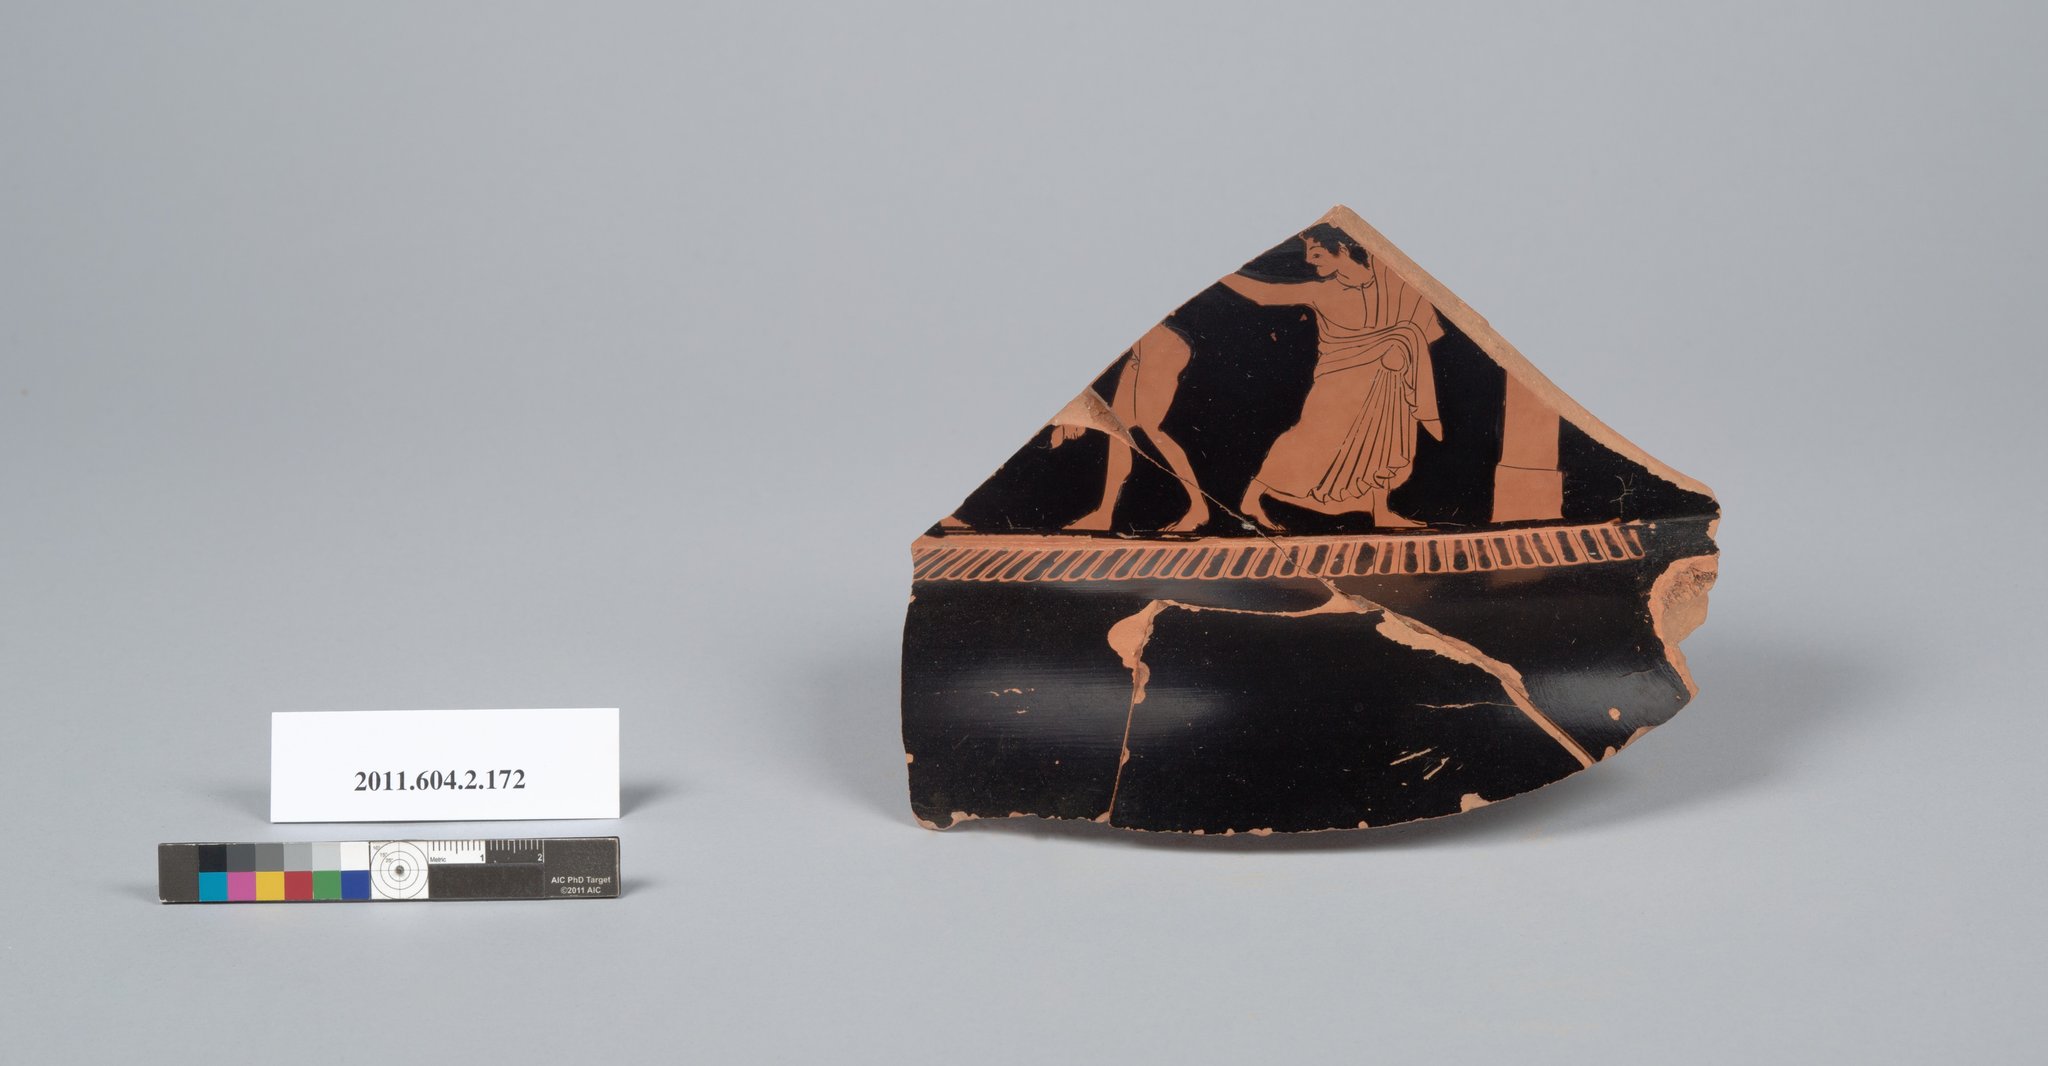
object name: volute krater fragment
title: Terracotta fragment of a volute-krater (bowl for mixing wine and water)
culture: greek, attic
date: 534-468 BCE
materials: terracotta